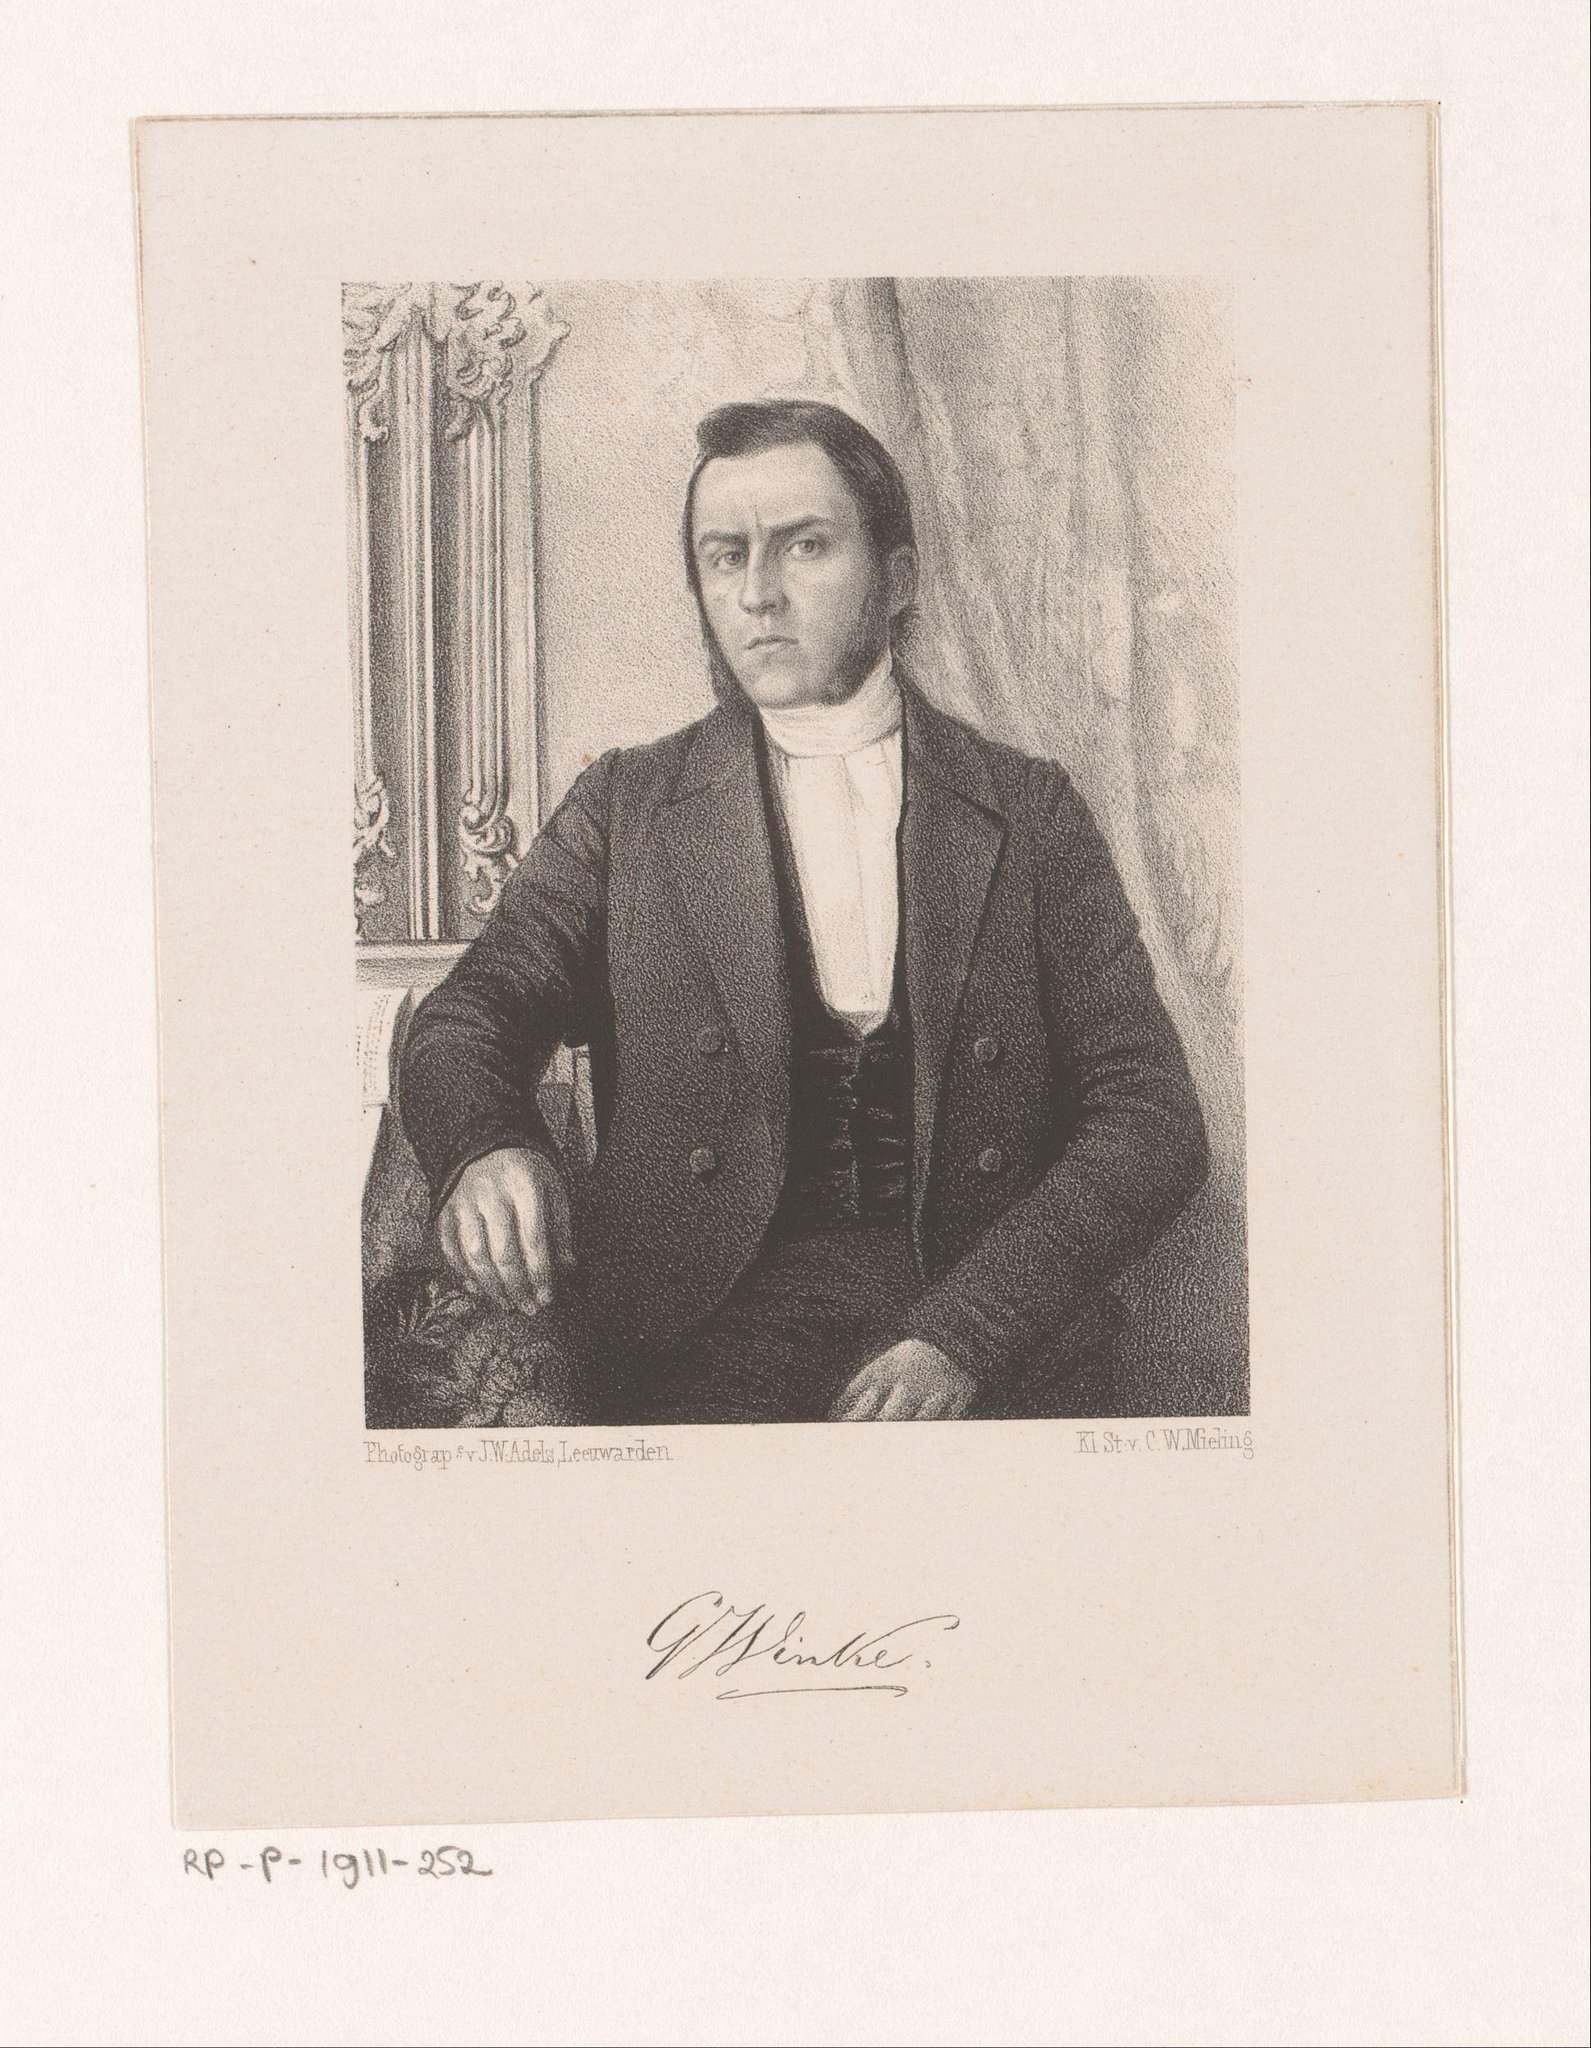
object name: print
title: Portret van Gerardus Johannes Vinke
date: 1854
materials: paper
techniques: lithograph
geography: the hague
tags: amsterdam, historical persons (+ half-length portrait)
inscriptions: collector's mark: Lugt 2228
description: De geportretteerde zit in een interieur. Onder het portret zijn signatuur.